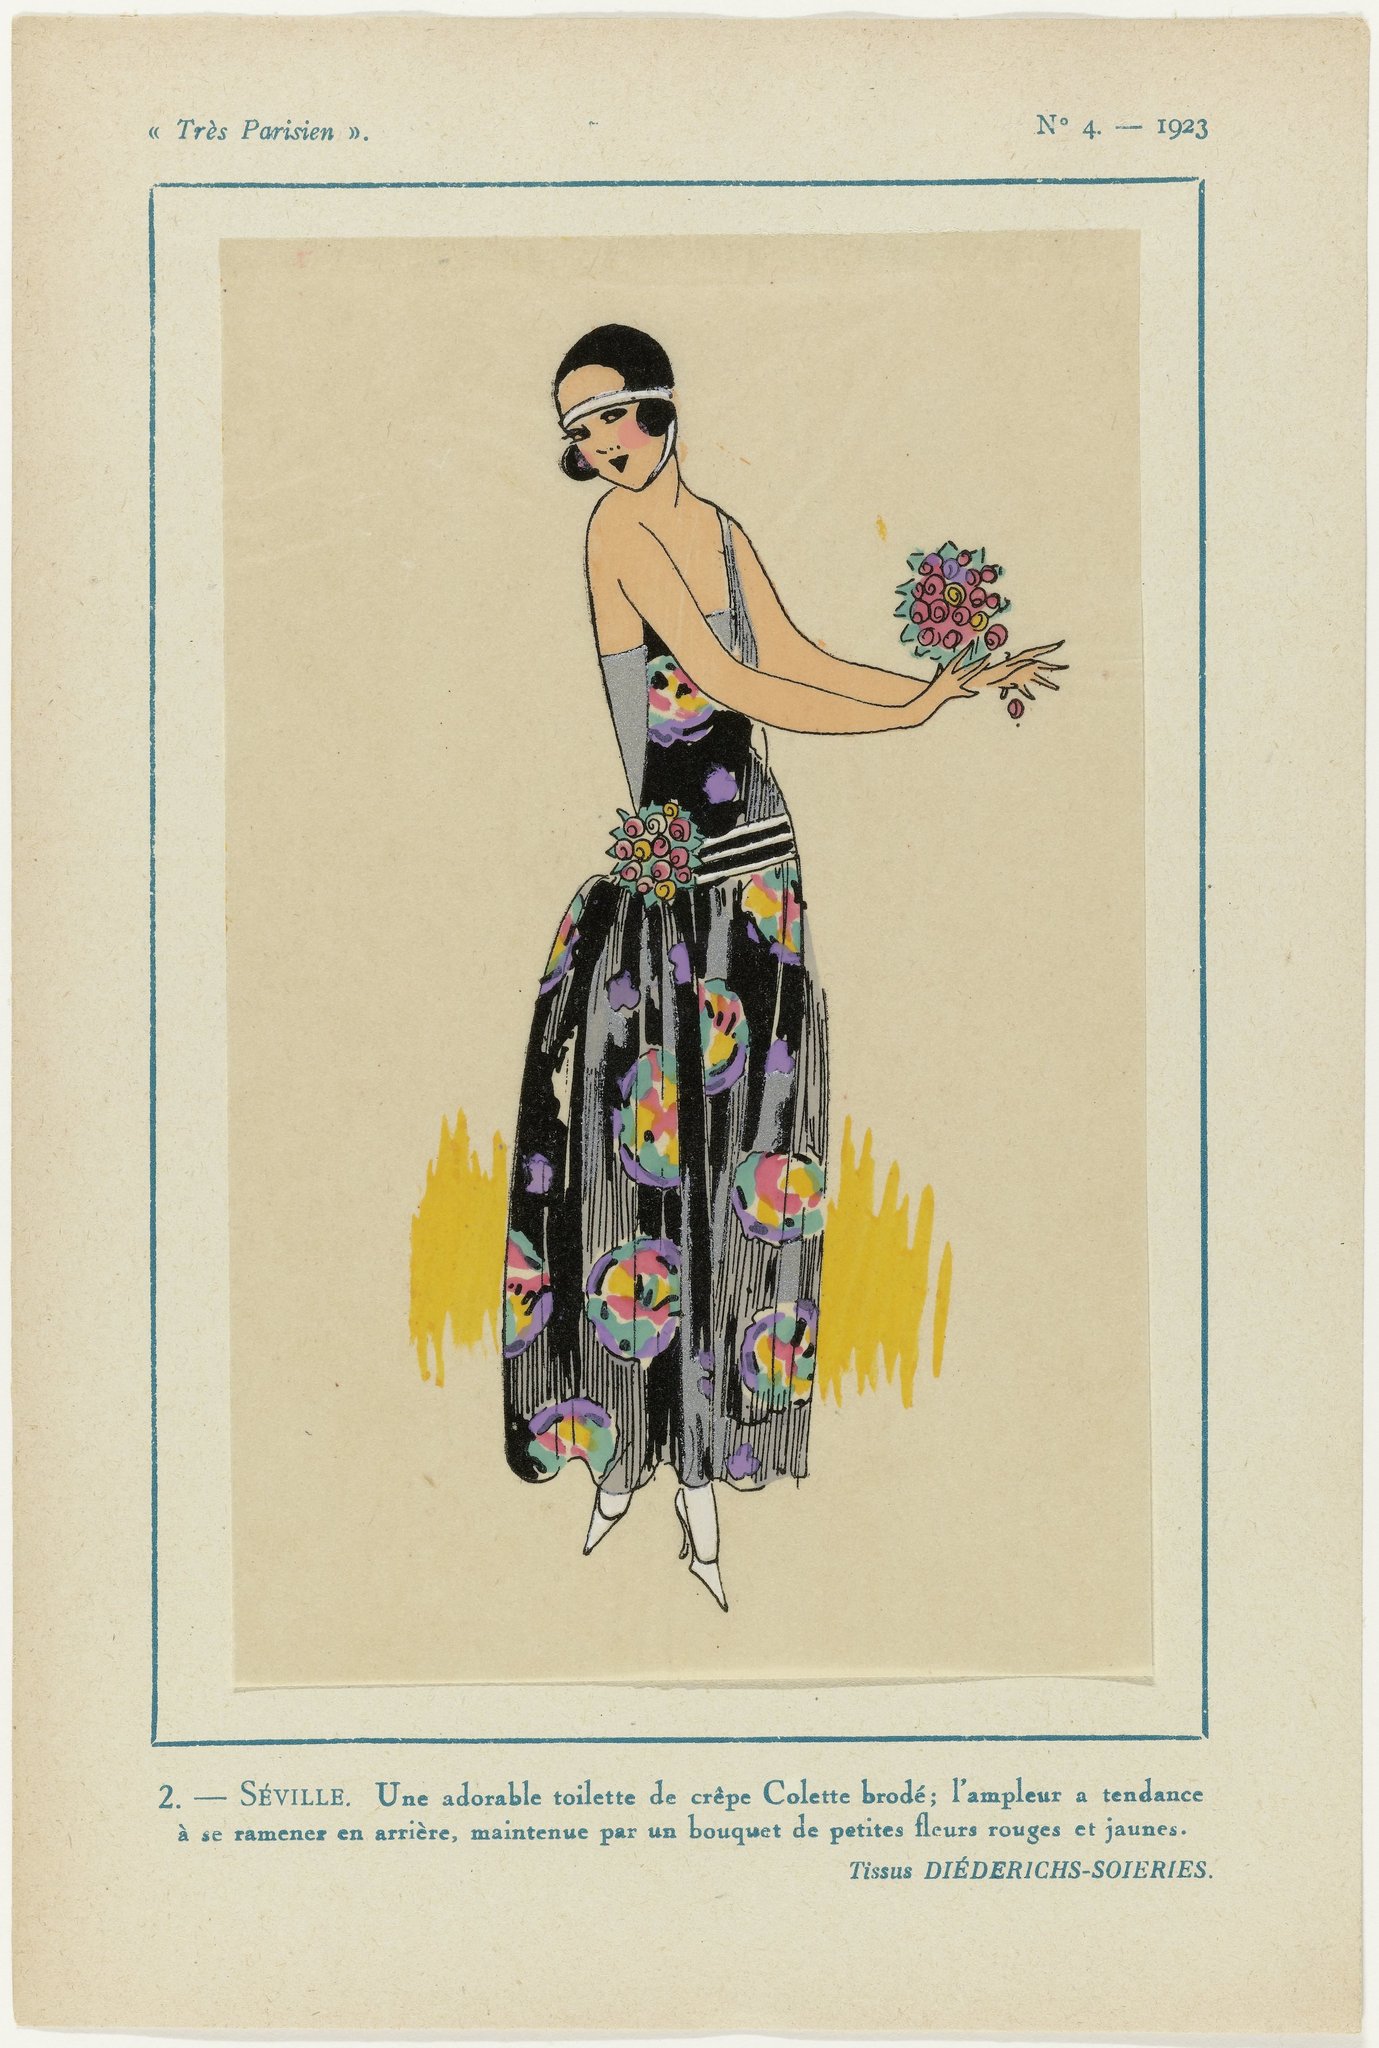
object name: fashion print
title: Très Parisien, 1923, No. 4: 2. - SÉVILLE. Une adorable toilette ....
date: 1923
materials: paper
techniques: hand coloring, letterpress printing, lithography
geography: paris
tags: corsage (+ women's clothes), cut flowers; nosegay, bunch of flowers, diadem, tiara (+ women's clothes), fashion plates, dress, gown (+ women's clothes)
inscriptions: title: ‘Très Parisien / No 4. - 1923’, caption: ‘2. - SÉVILLE. Une adorable toilette de crêpe Colette brodé; l'ampleur a tendance à se ramener en arrière, maintenue par un bouquet de petites fleurs rouges et jaunes. / Tissus DIÉDERICHS-SOIERIES.’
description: Stoffen van Diéderichs-Soieries. 'Toilette' van geborduurde 'crêpe Colette'. Accessoires: hoofdband, bloemcorsage, pumps. Prent uit het modetijdschrift Très Parisien (1920-1936).